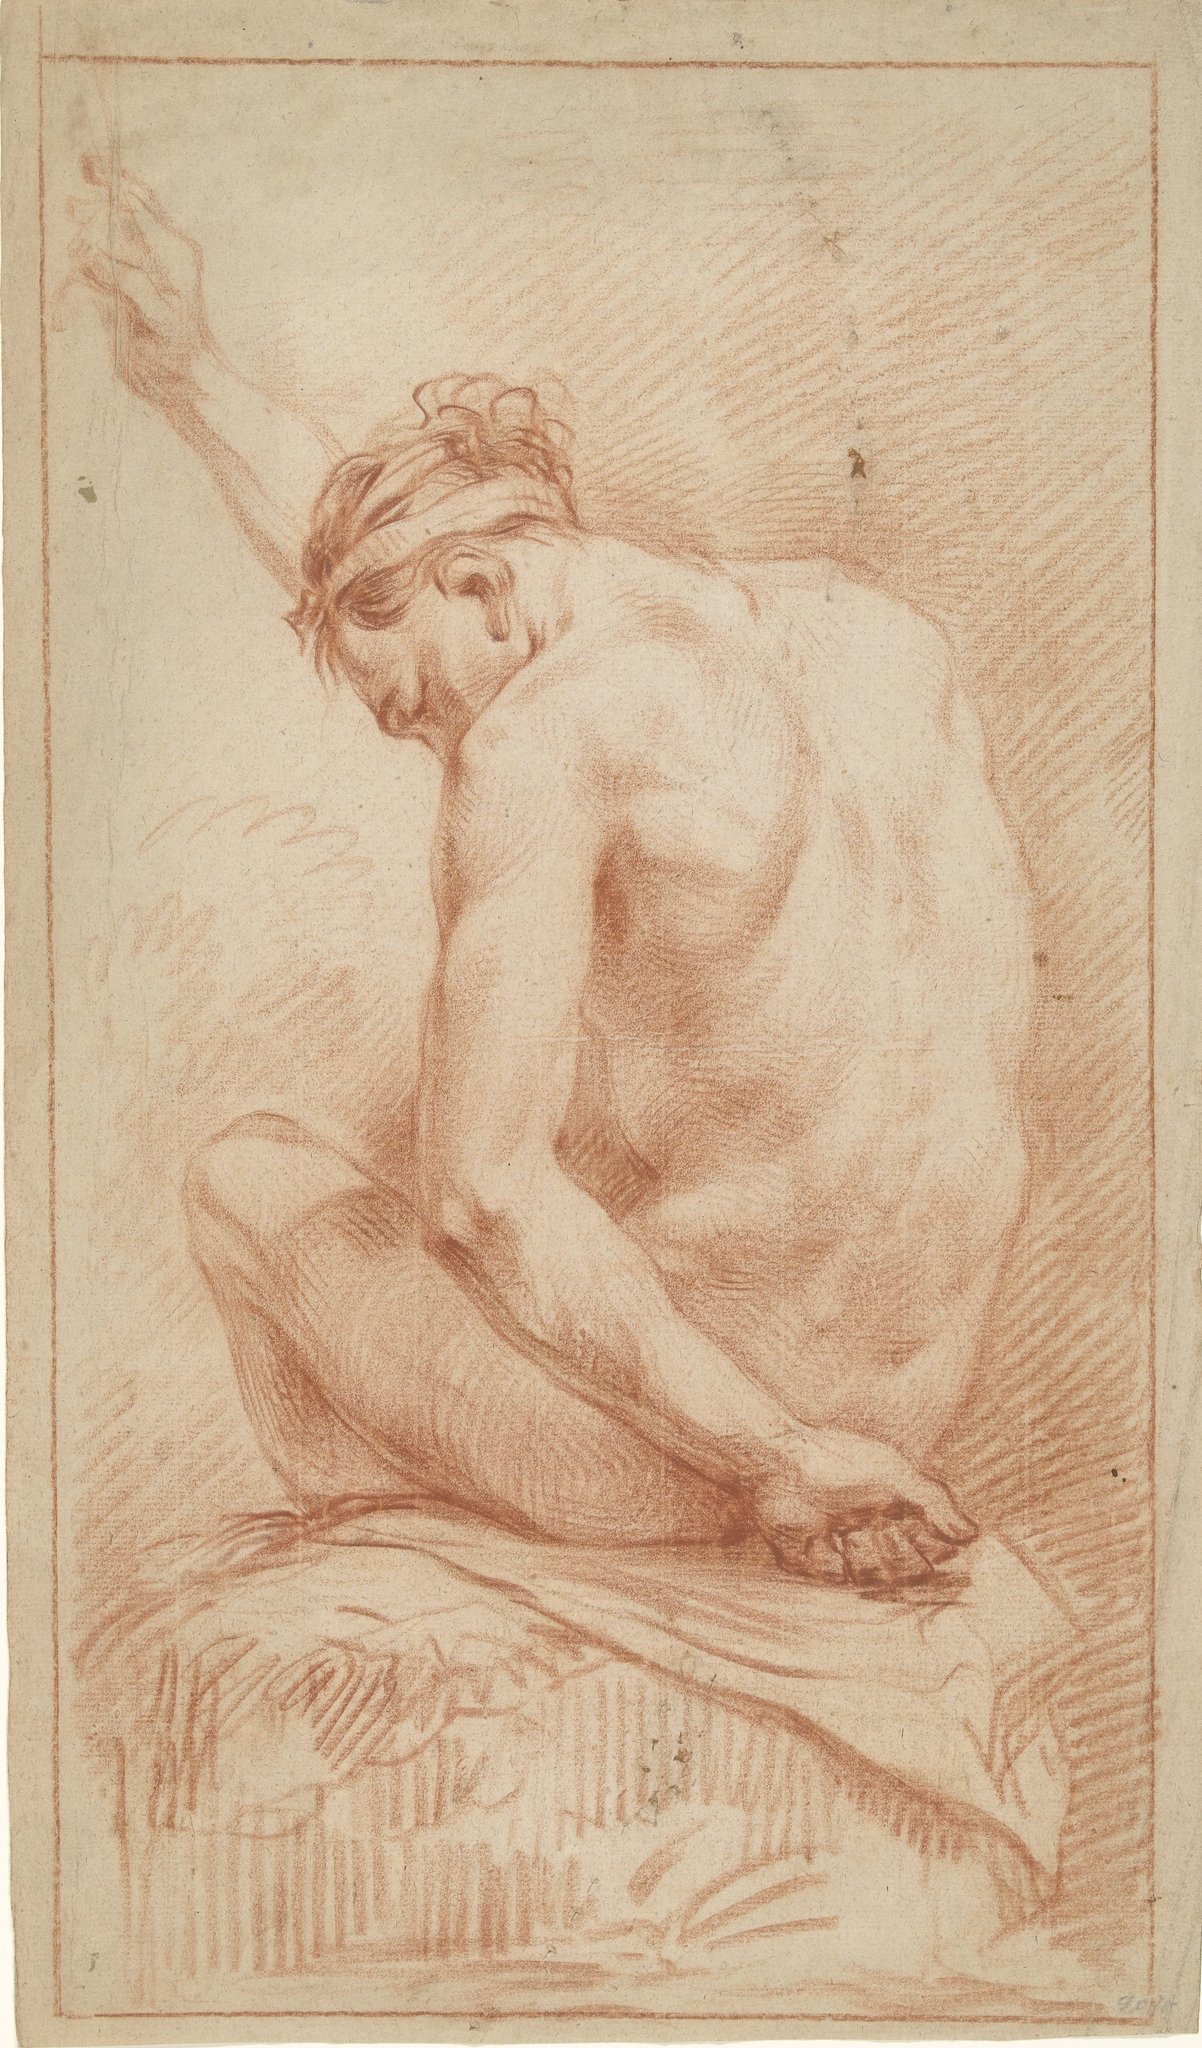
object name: drawing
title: Zittend mannelijk naakt, iets naar links, op de rug gezien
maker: Anonymous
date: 1700-1800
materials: chalk, paper